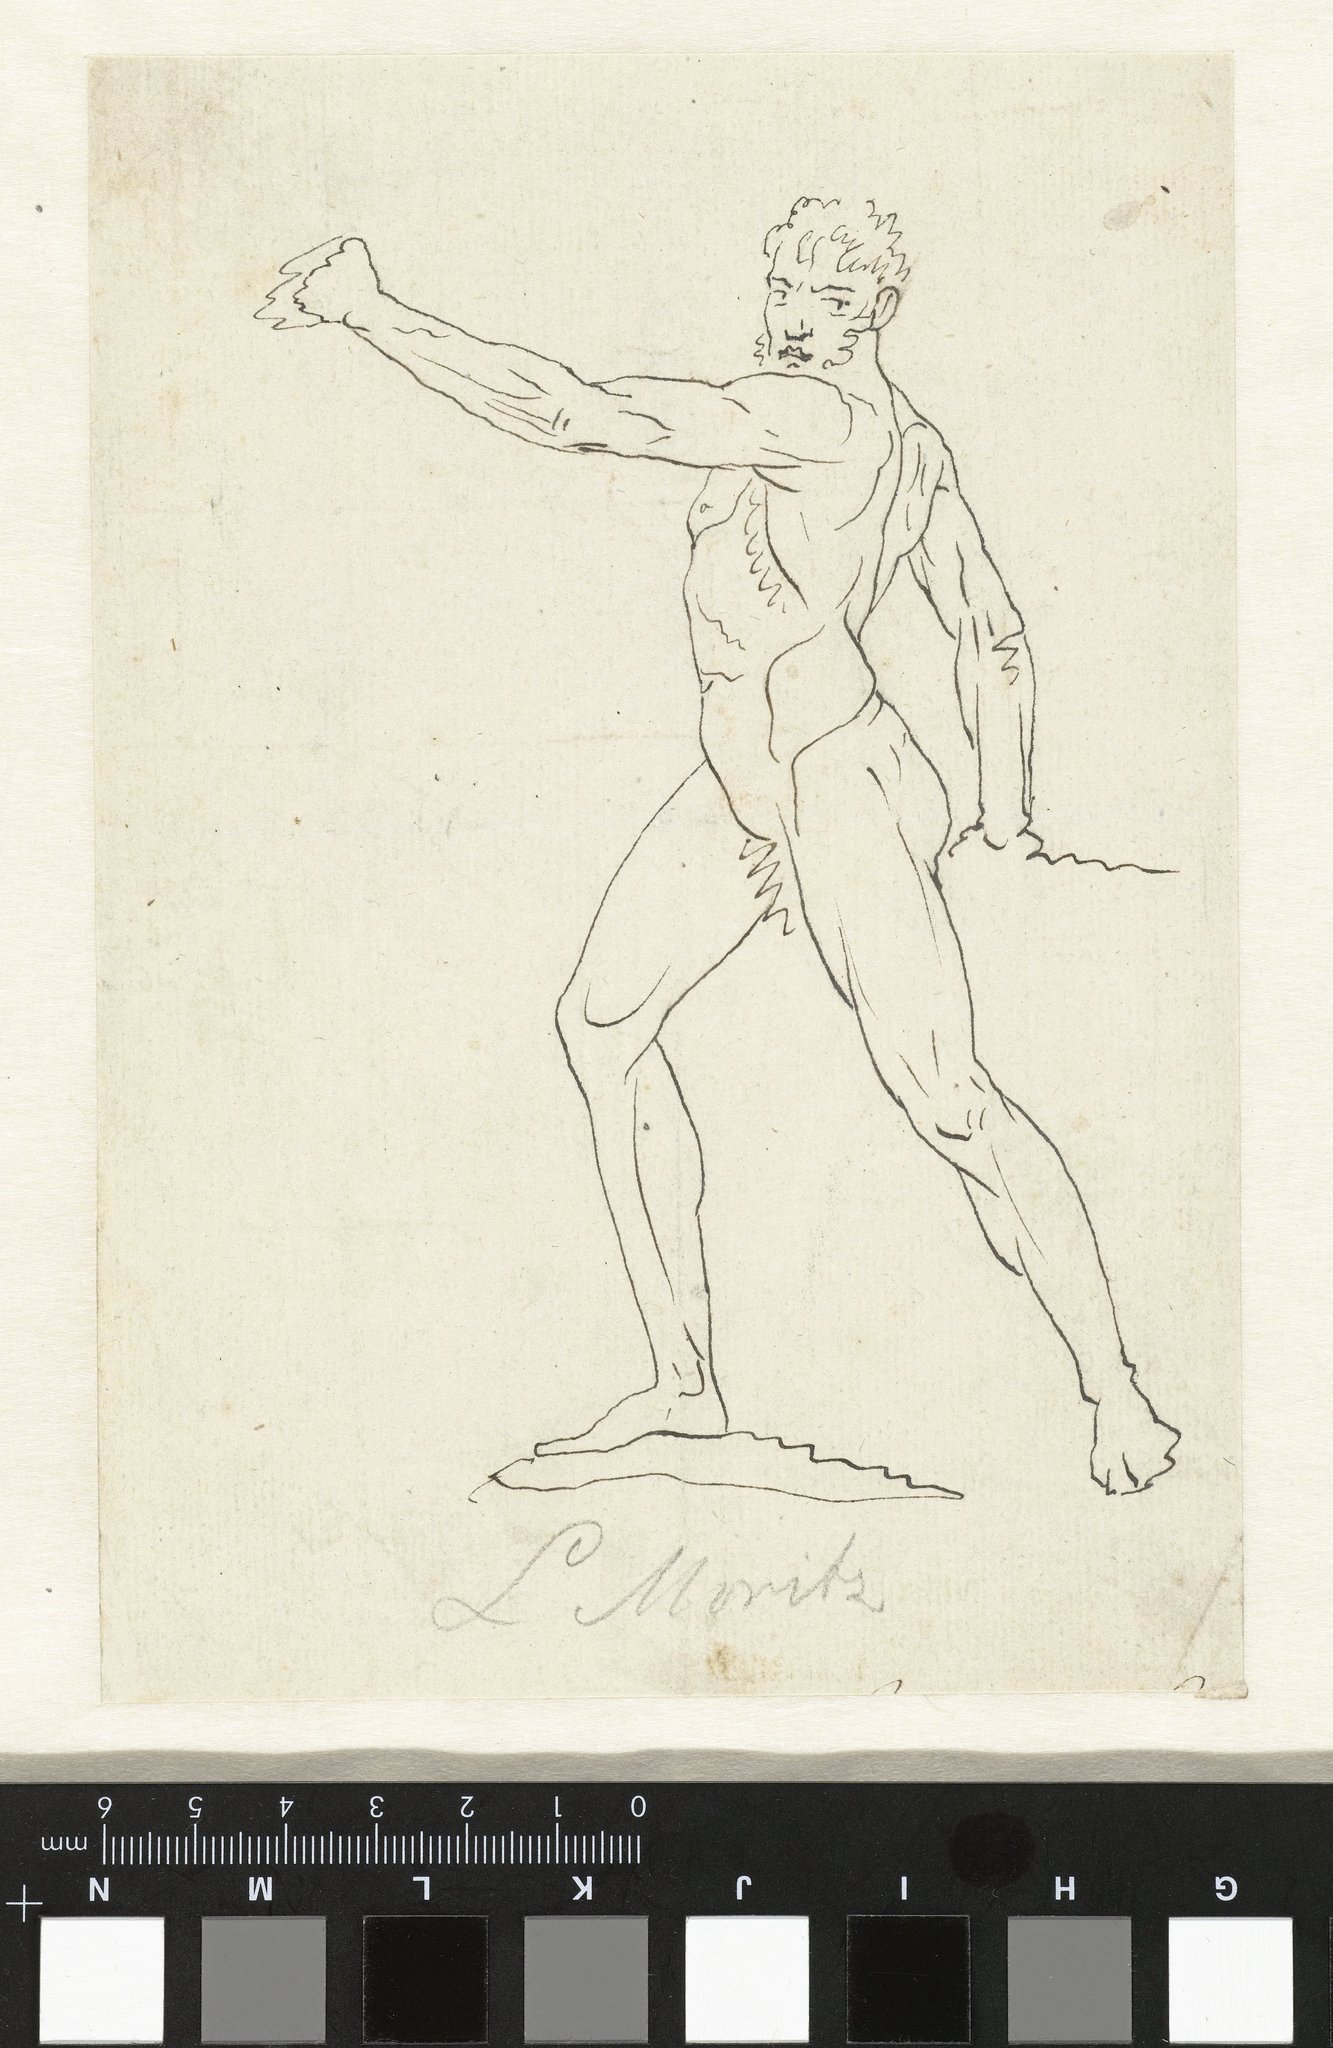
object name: drawing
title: Staand mannelijk naakt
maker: louis moritz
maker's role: draughtsman, painter, print maker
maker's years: 1773-1850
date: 1783-1850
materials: ink, paper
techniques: pen